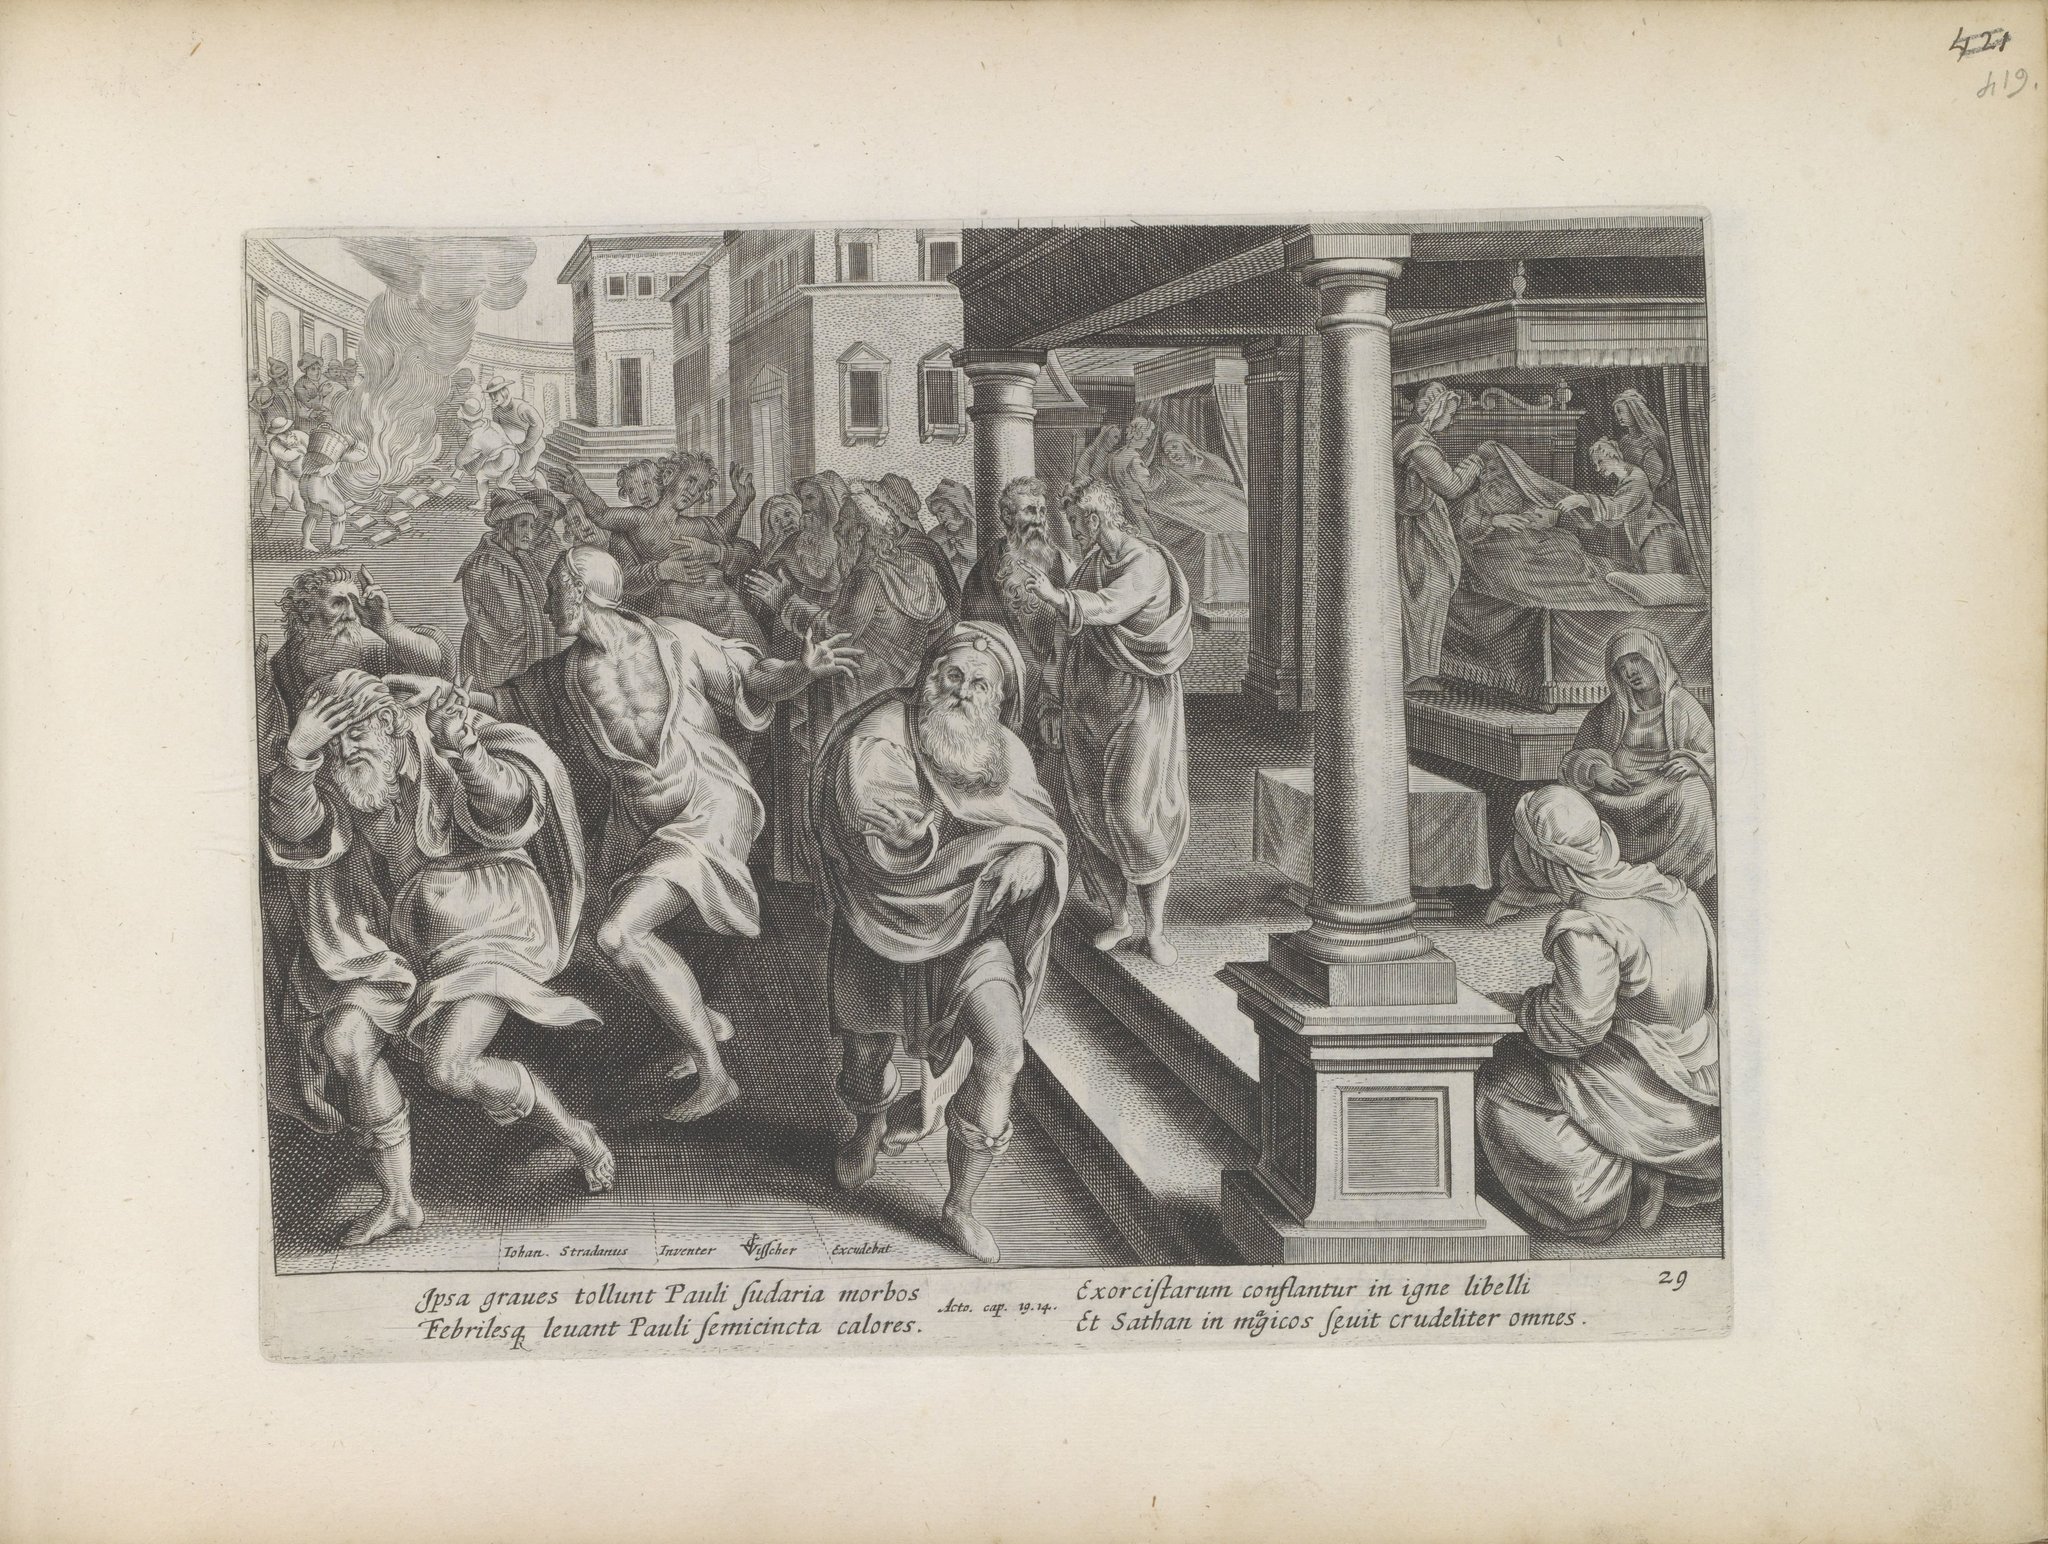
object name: album leaf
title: Paulus en de geestenbezweerders van Efeze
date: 1643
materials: paper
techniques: engraving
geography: amsterdam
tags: the ephesians burn the exorcists' books in public, seven exorcists, sons of sceva, are beaten by a man with an evil spirit, and flee, paul's handkerchiefs and aprons cure the sick and possessed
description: Joodse geestenbezweerders proberen, in navolging van Paulus, een boze geest uit te drijven bij een bezeten man, maar de man valt ze aan zodat ze naakt en gewond wegvluchten. Rechts worden de doeken en werkkleren van Paulus naar zieken gebracht, zodat ze genezen en boze geesten hen verlaten. Op de achtergrond verbranden nieuwe gelovigen hun magieboeken. Onder de voorstelling een verwijzing in het Latijn naar de Bijbeltekst in Hand. 19:14. Deze prent maakt deel uit van een album.